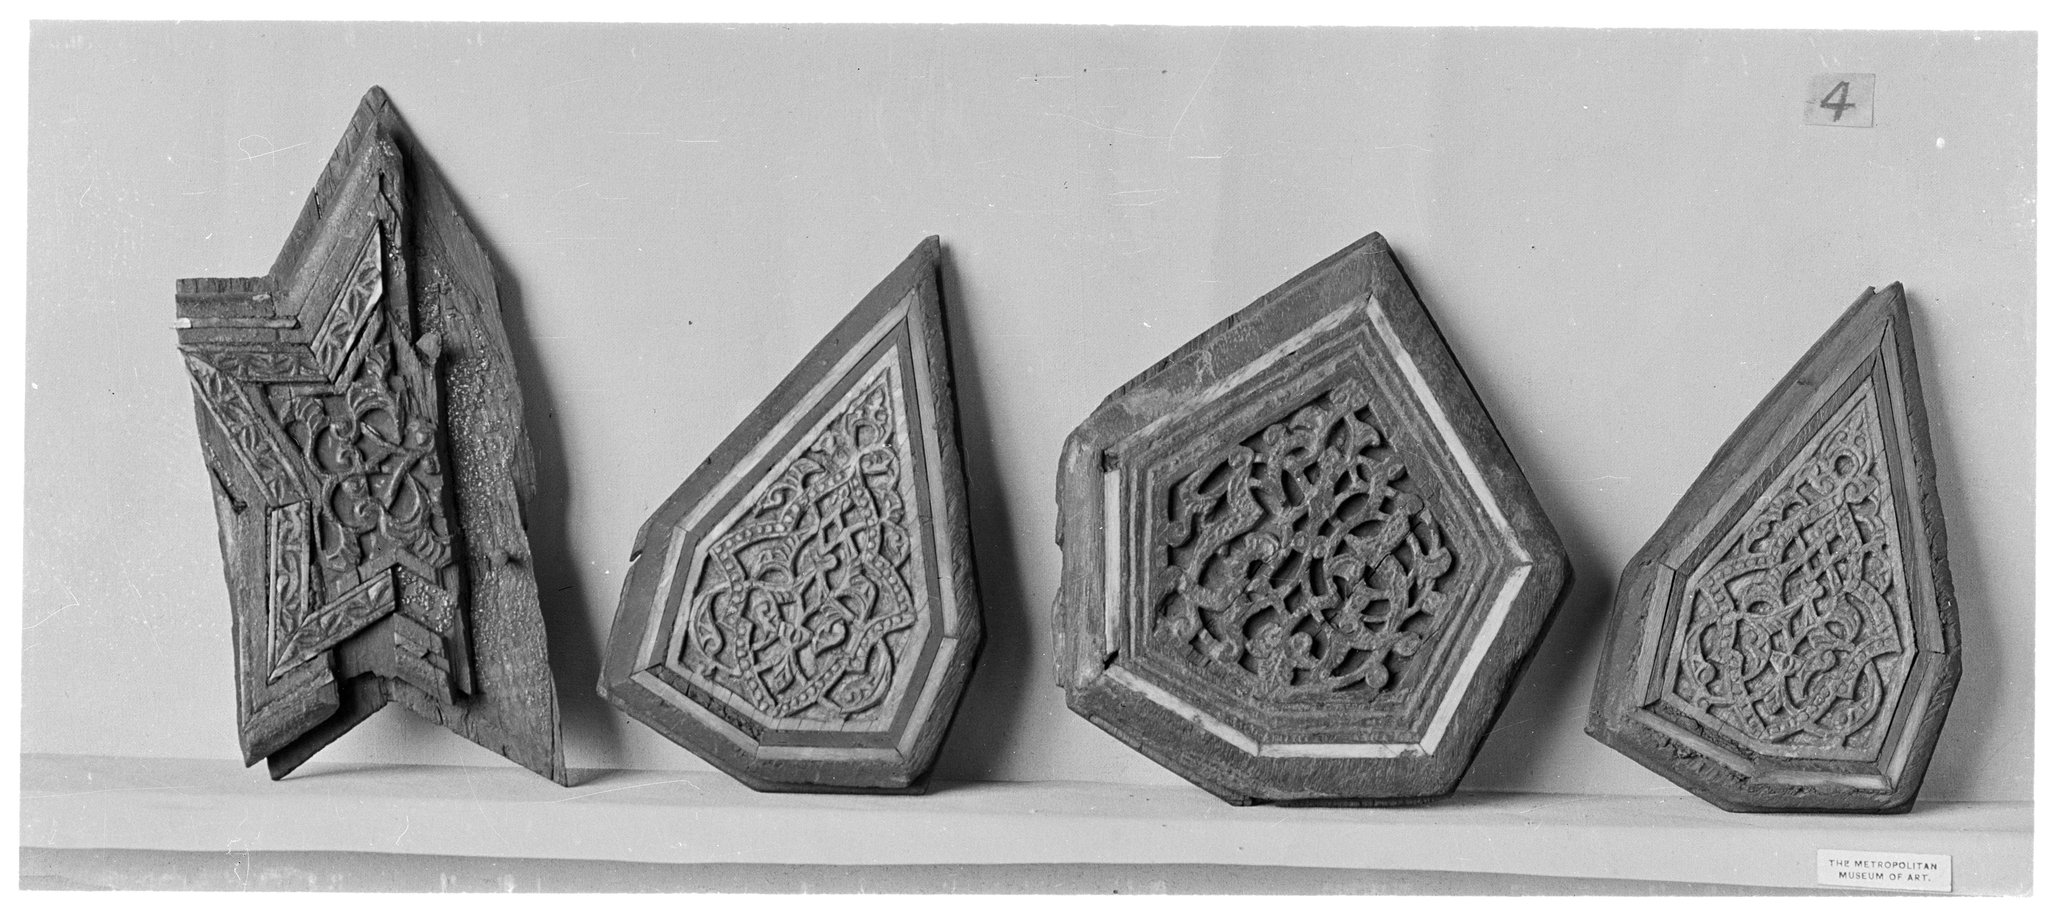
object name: panel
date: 1201-1400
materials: ivory, wood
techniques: carving, inlay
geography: egypt